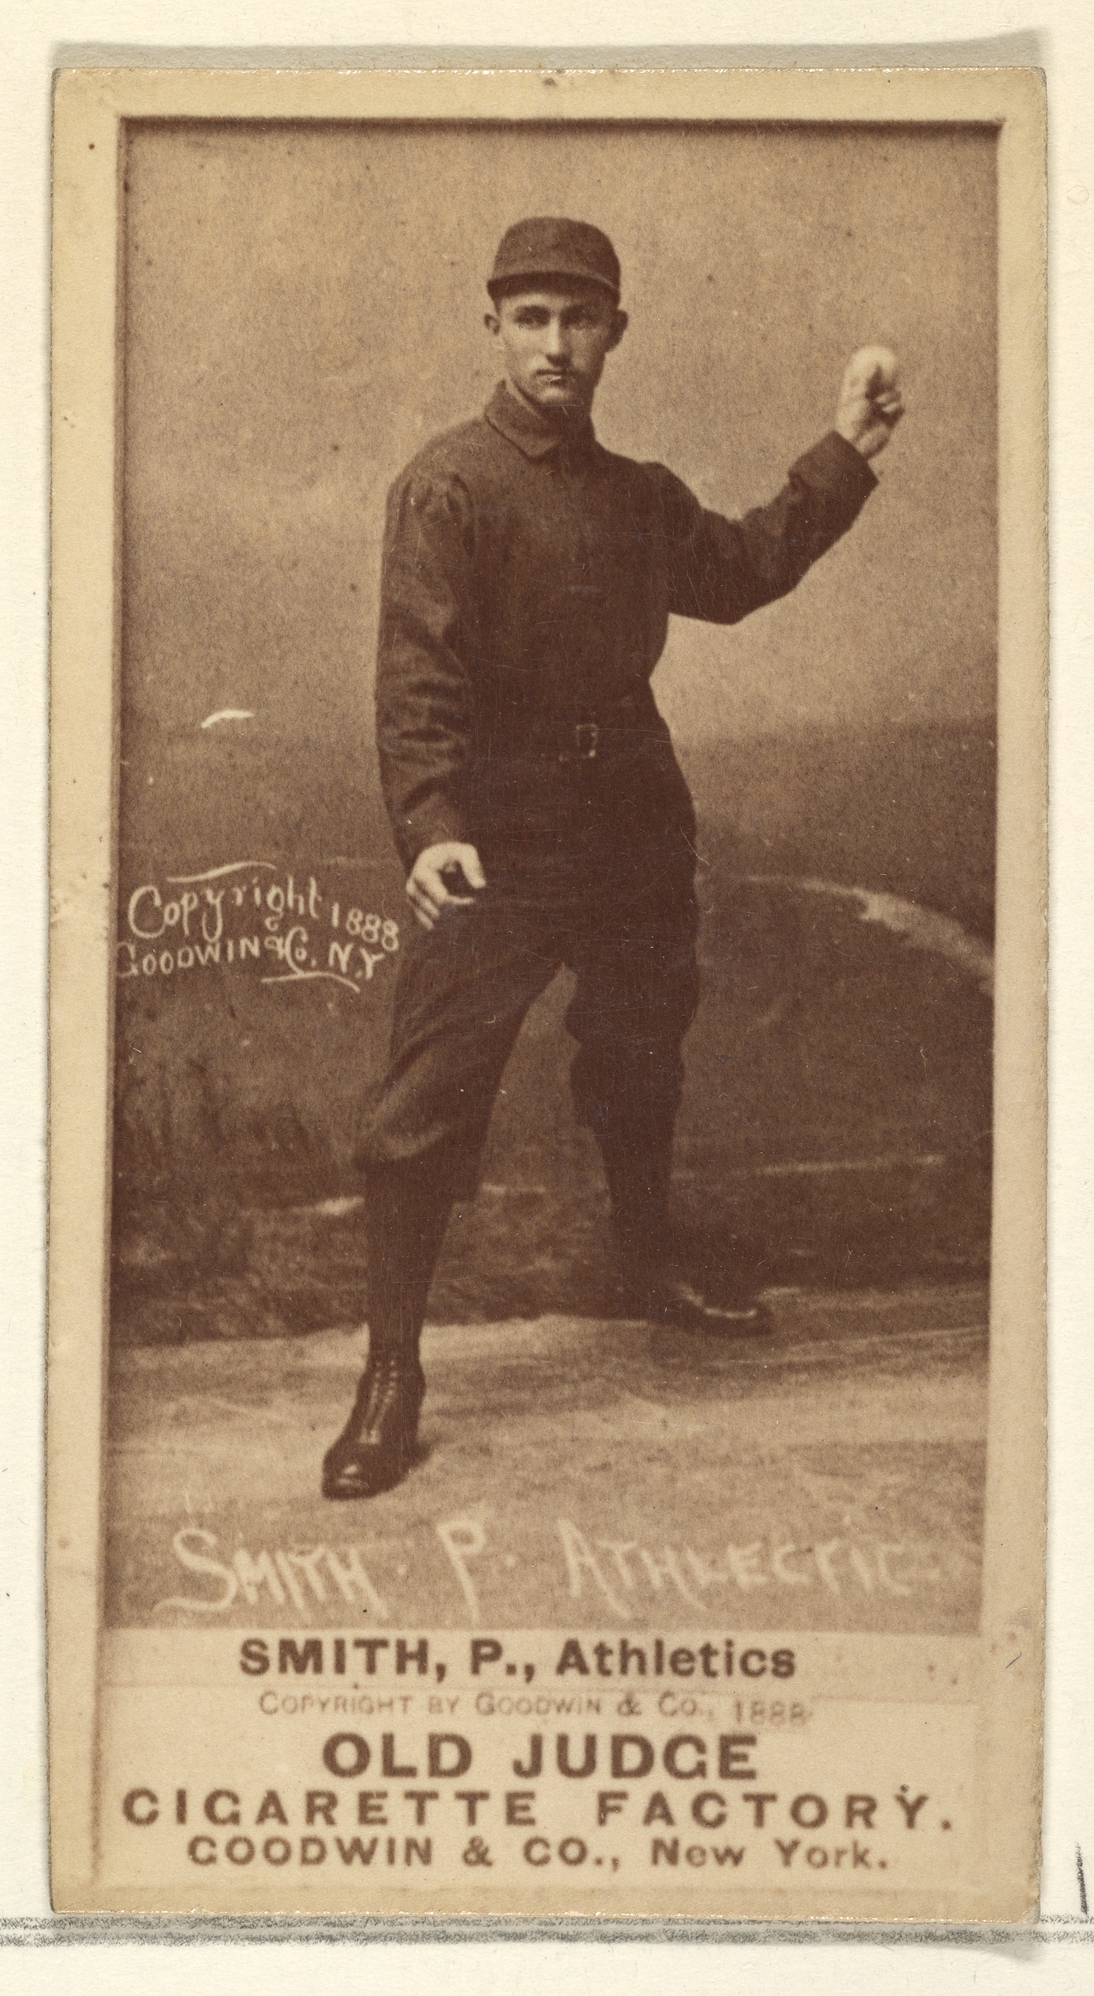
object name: baseball card, photograph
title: Smith, Pitcher, Philadelphia Athletics, from the Old Judge series (N172) for Old Judge Cigarettes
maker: goodwin & company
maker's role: publisher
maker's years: 1850-1950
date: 1888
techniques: albumen silver print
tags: men,portraits,baseball,athletes